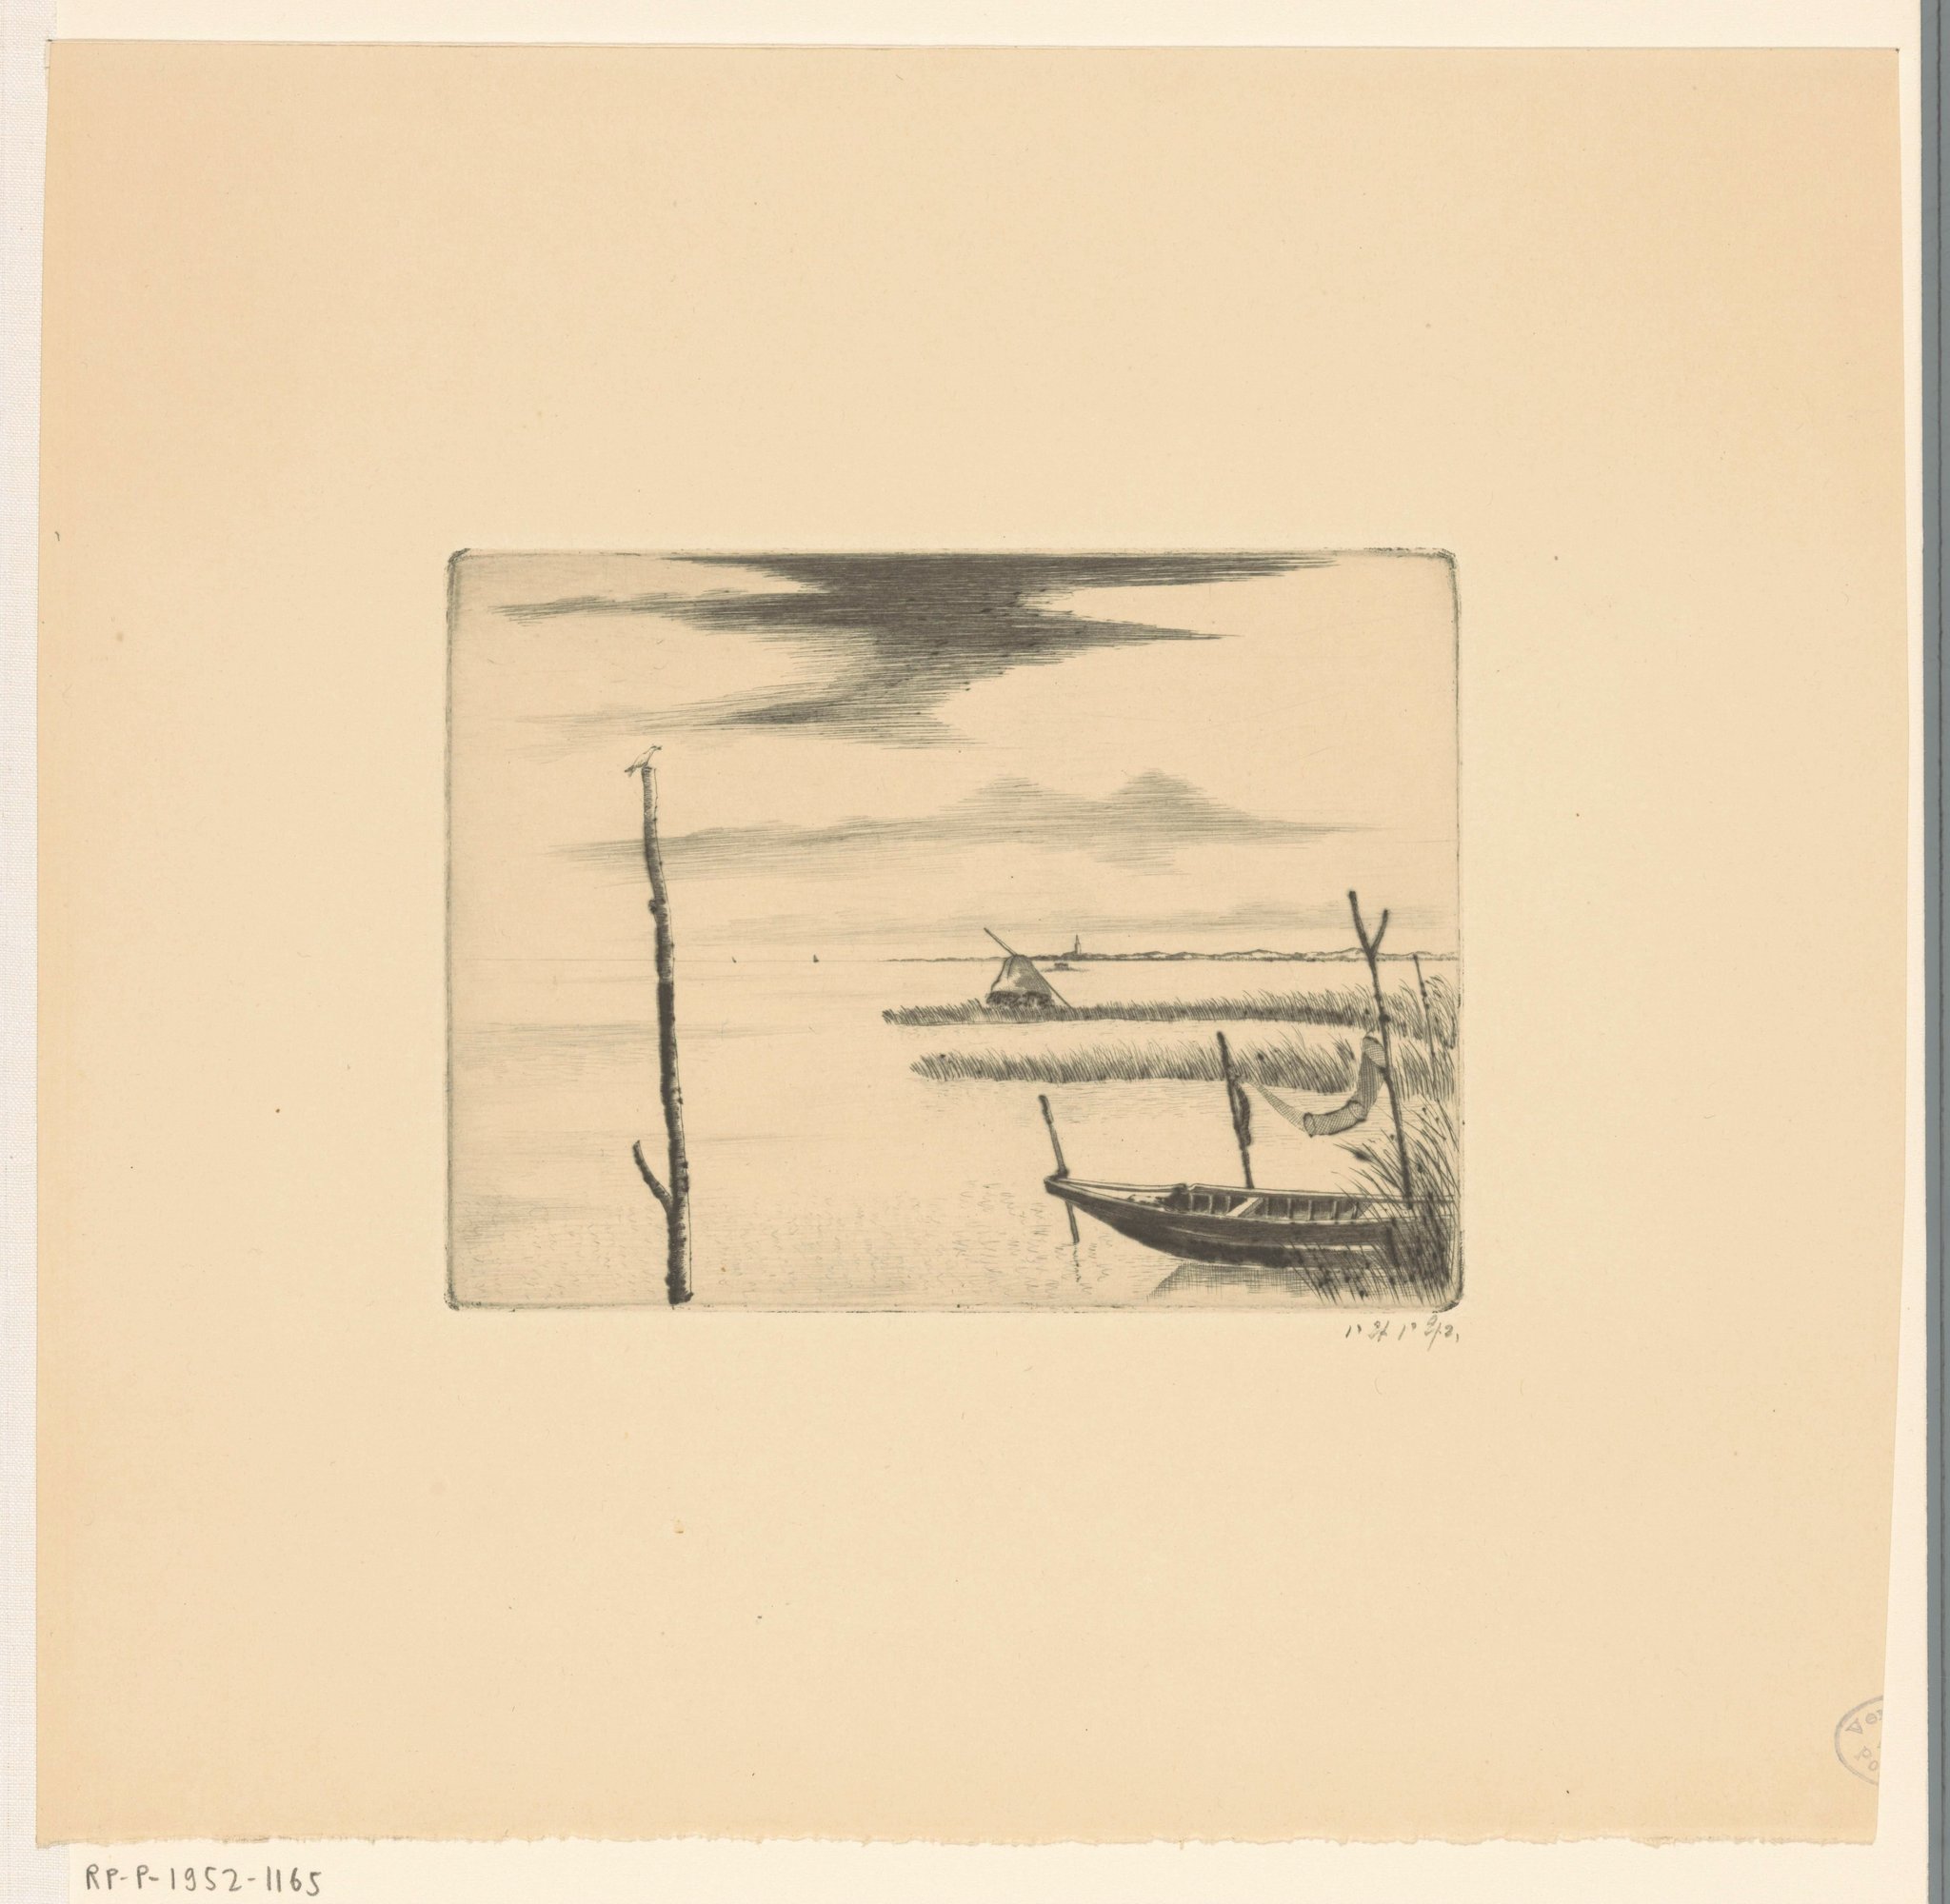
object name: print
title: Le Lac de Kortenhoef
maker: lodewijk schelfhout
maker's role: draughtsman, print maker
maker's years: 1881-1943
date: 1936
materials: paper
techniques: drypoint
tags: rowing-boat, canoe, etc., lake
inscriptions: collector's mark: Lugt 2228, collector's mark: Lugt 5i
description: Rechts op de voorgrond een afgemeerde schuit.